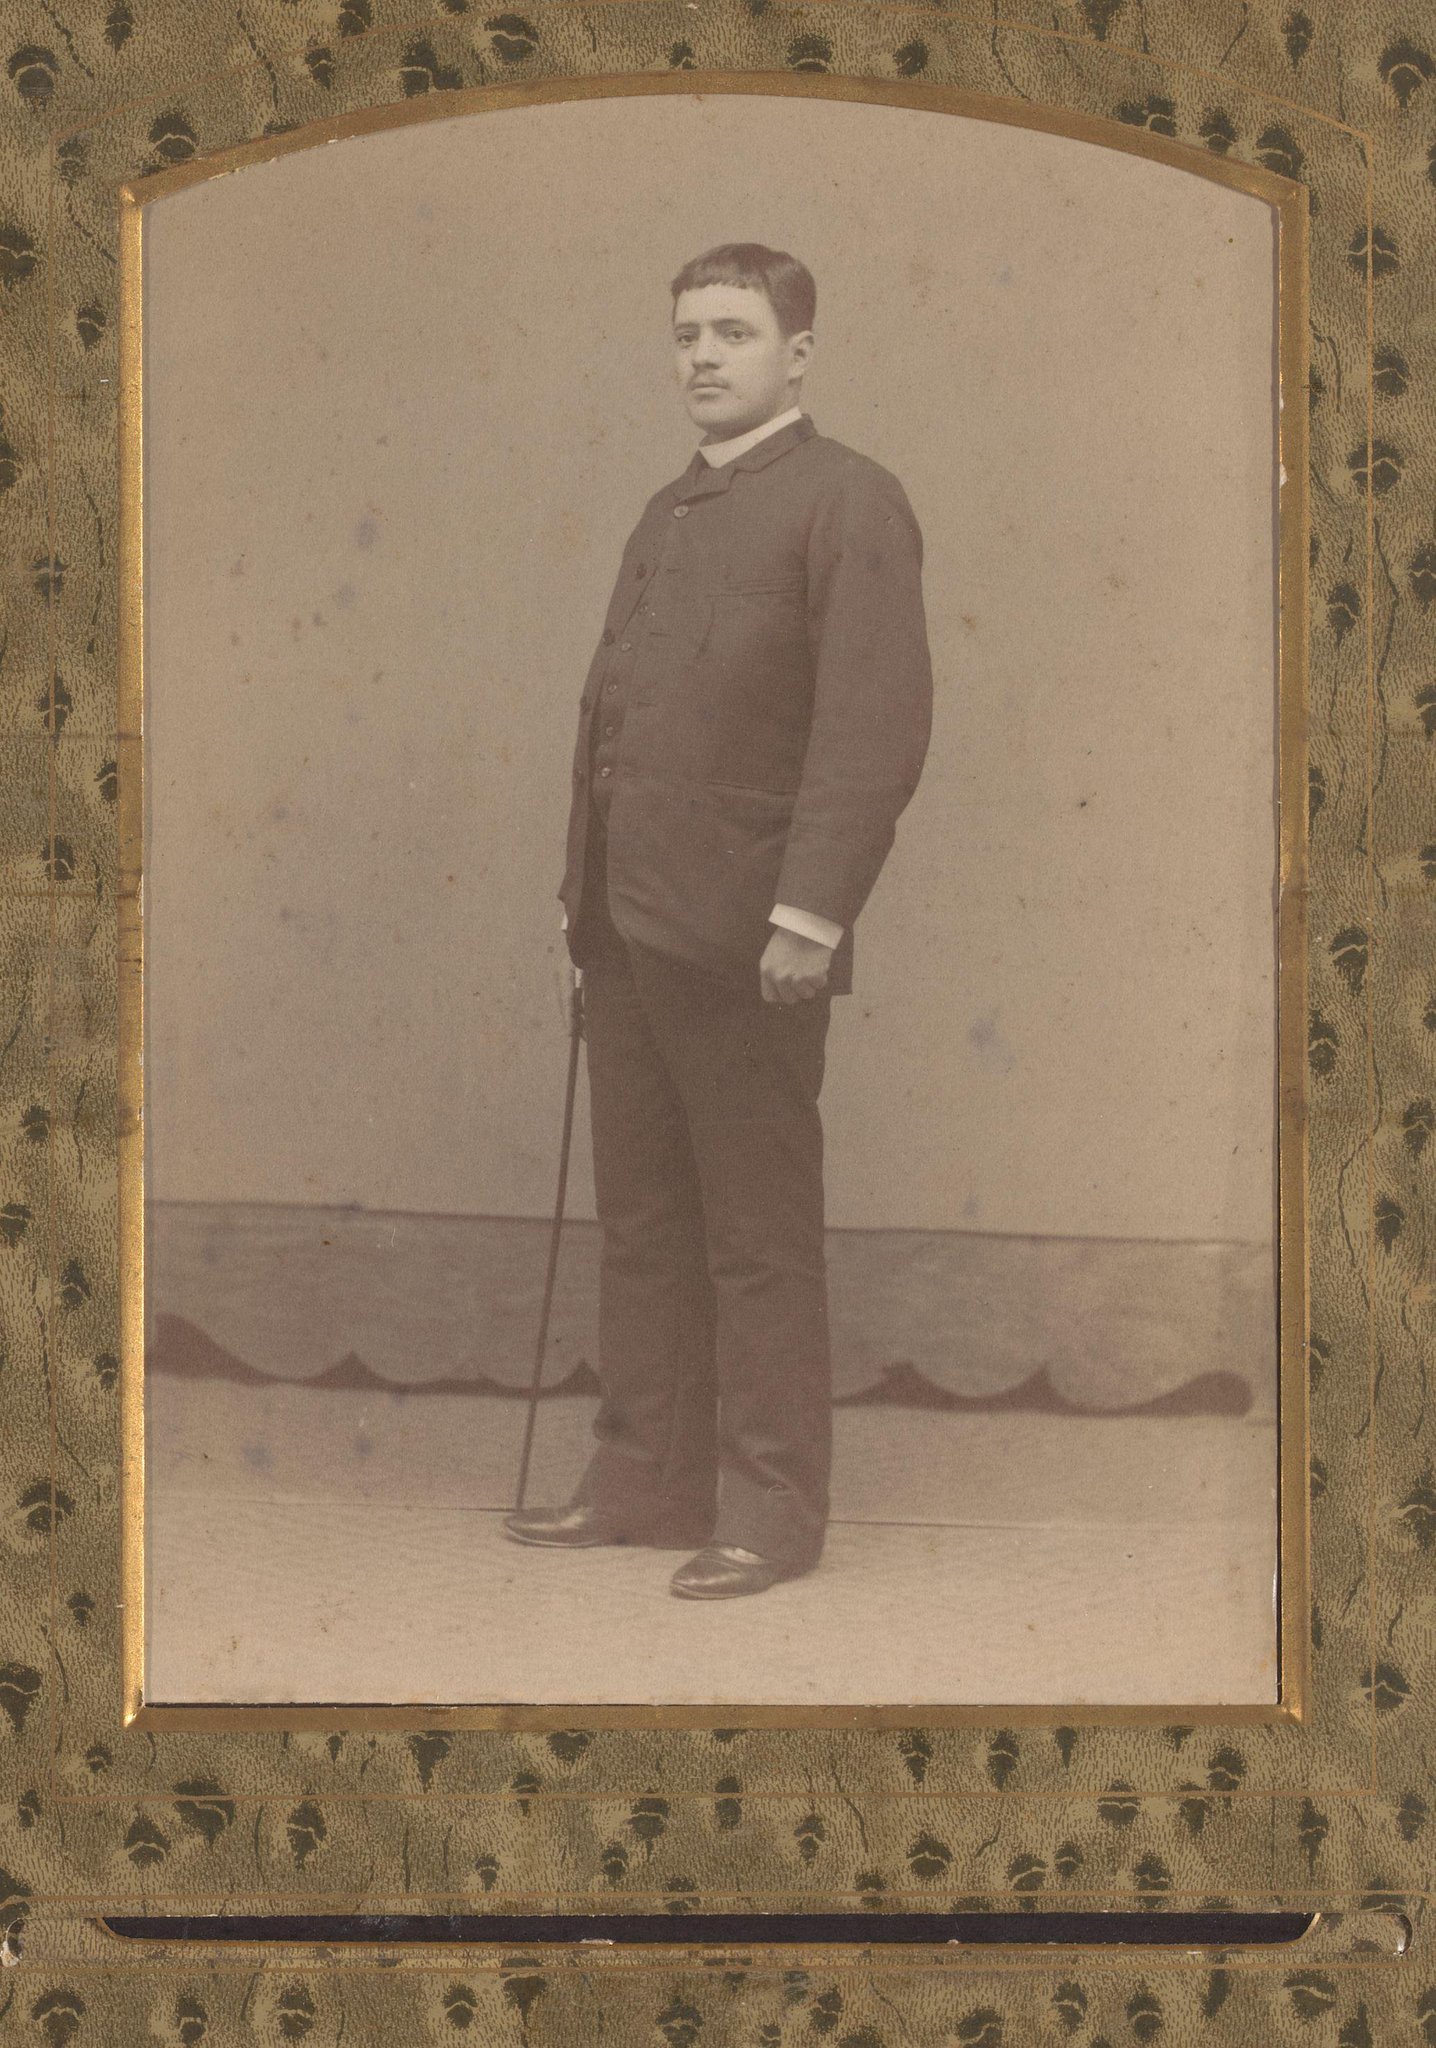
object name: album leaf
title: Portret van een man met wandelstok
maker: a. kit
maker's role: fotograaf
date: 1880-1900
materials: cardboard, photographic support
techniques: albumen print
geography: indo-china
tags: walking-stick, staff, historical persons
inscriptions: inscription: ‘A-KIT./ PHOTOGRAPHE ET PEINTRE DE/ PORTRAIT/ AU PREMIER/ No. 1, Rue de Chinois No. 1,/ HAIPHONG, PRIX MODERES./ (...)’